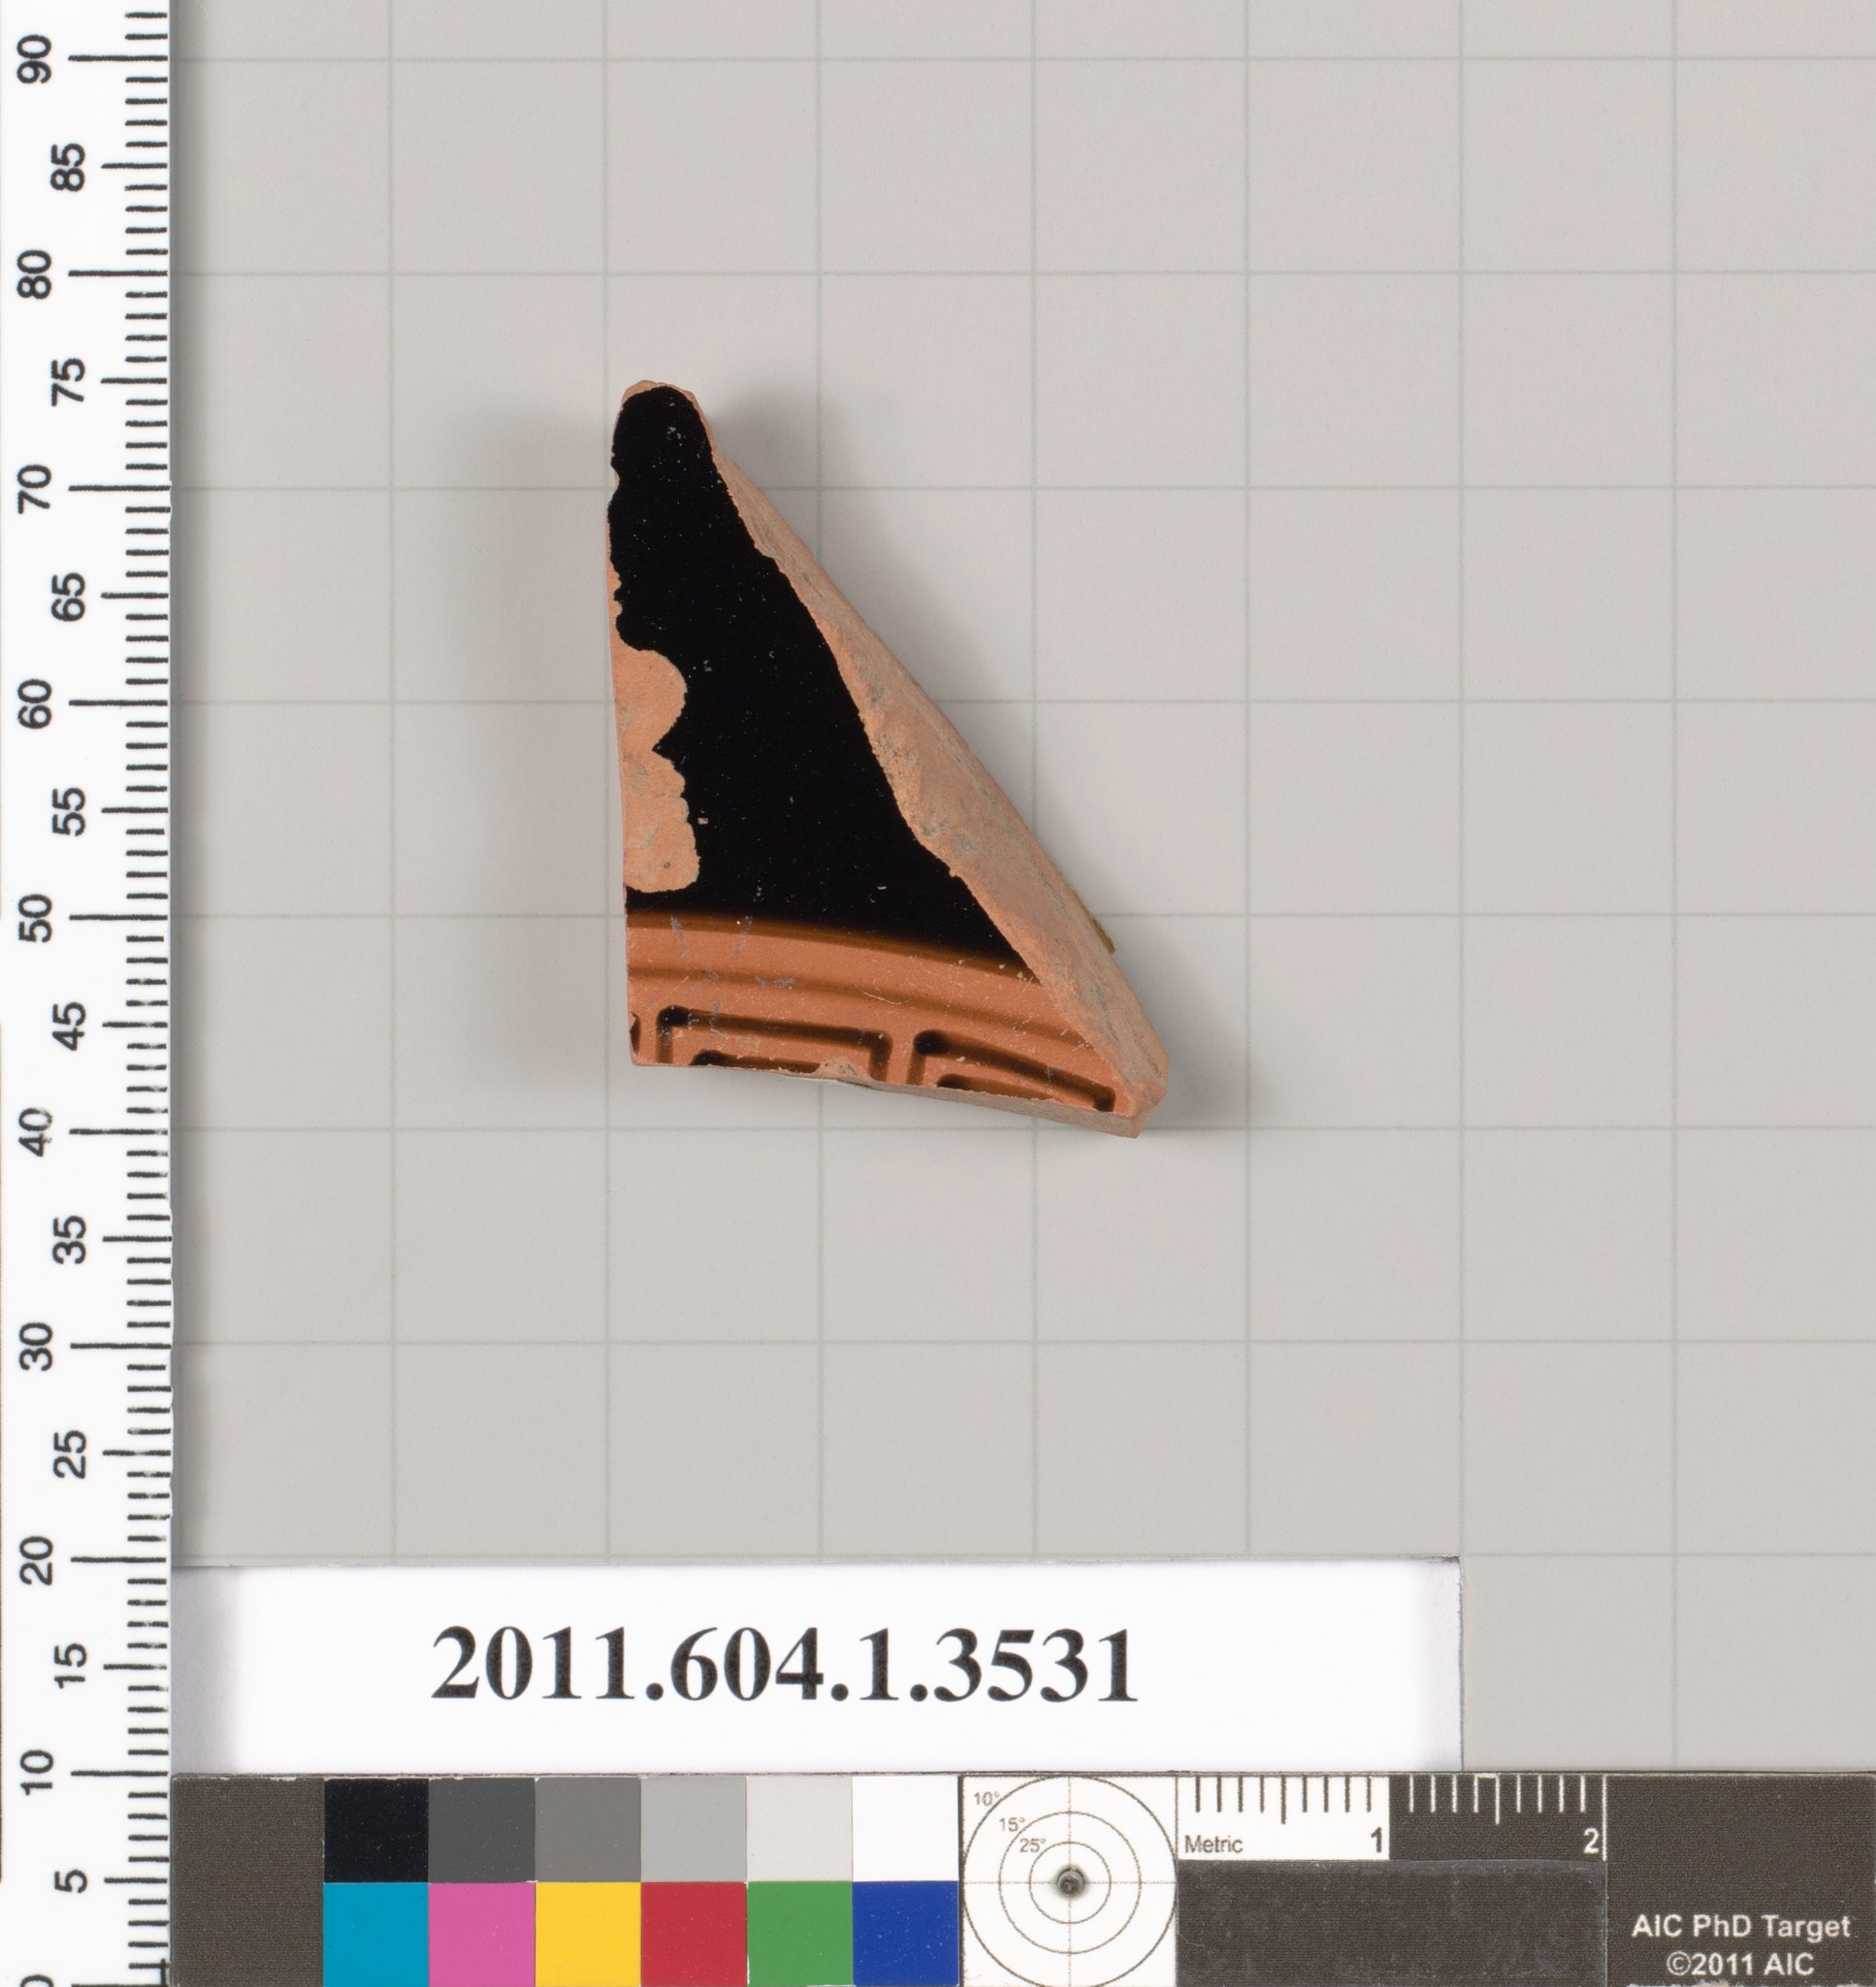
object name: kylix fragment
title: Terracotta fragment of a kylix (drinking cup)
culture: greek, attic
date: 475-451 BCE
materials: terracotta